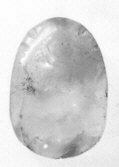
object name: stamp seal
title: Scarab seal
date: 1700-1560 BCE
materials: gemstone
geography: levant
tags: scarabs